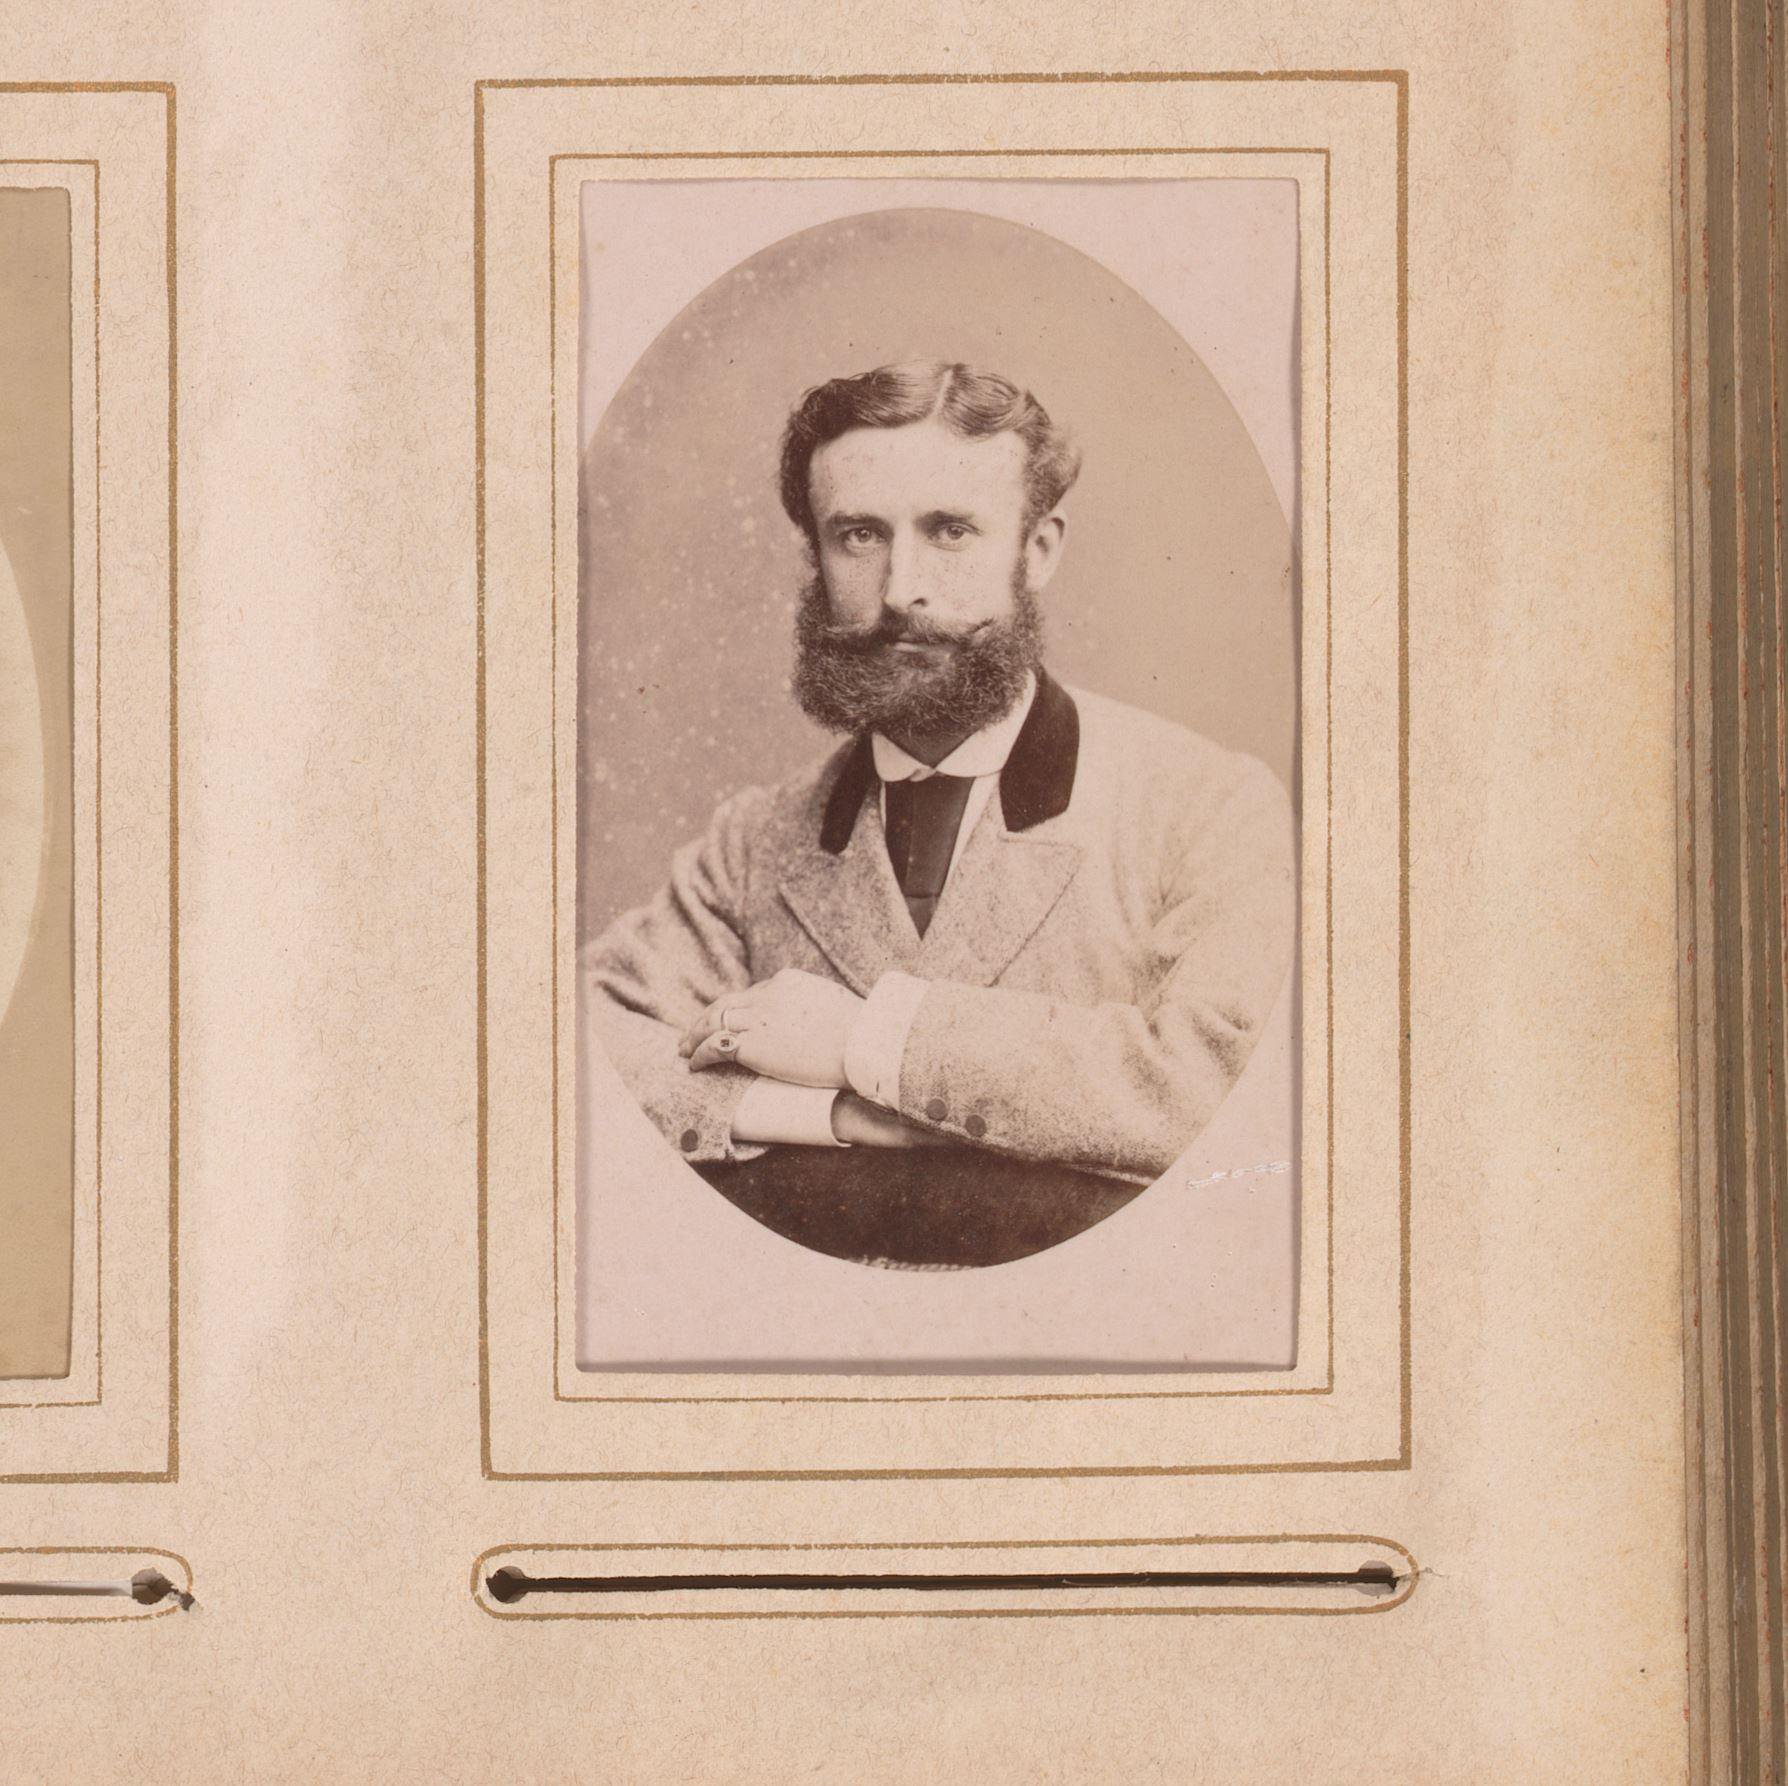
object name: carte de visite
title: Portret van een man met baard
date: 1860-1885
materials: cardboard, photographic support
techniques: albumen print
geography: venice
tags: historical persons, beard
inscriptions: inscription: ‘Fratelli Vianelli/ Fotografe de S.M.L. Re.’